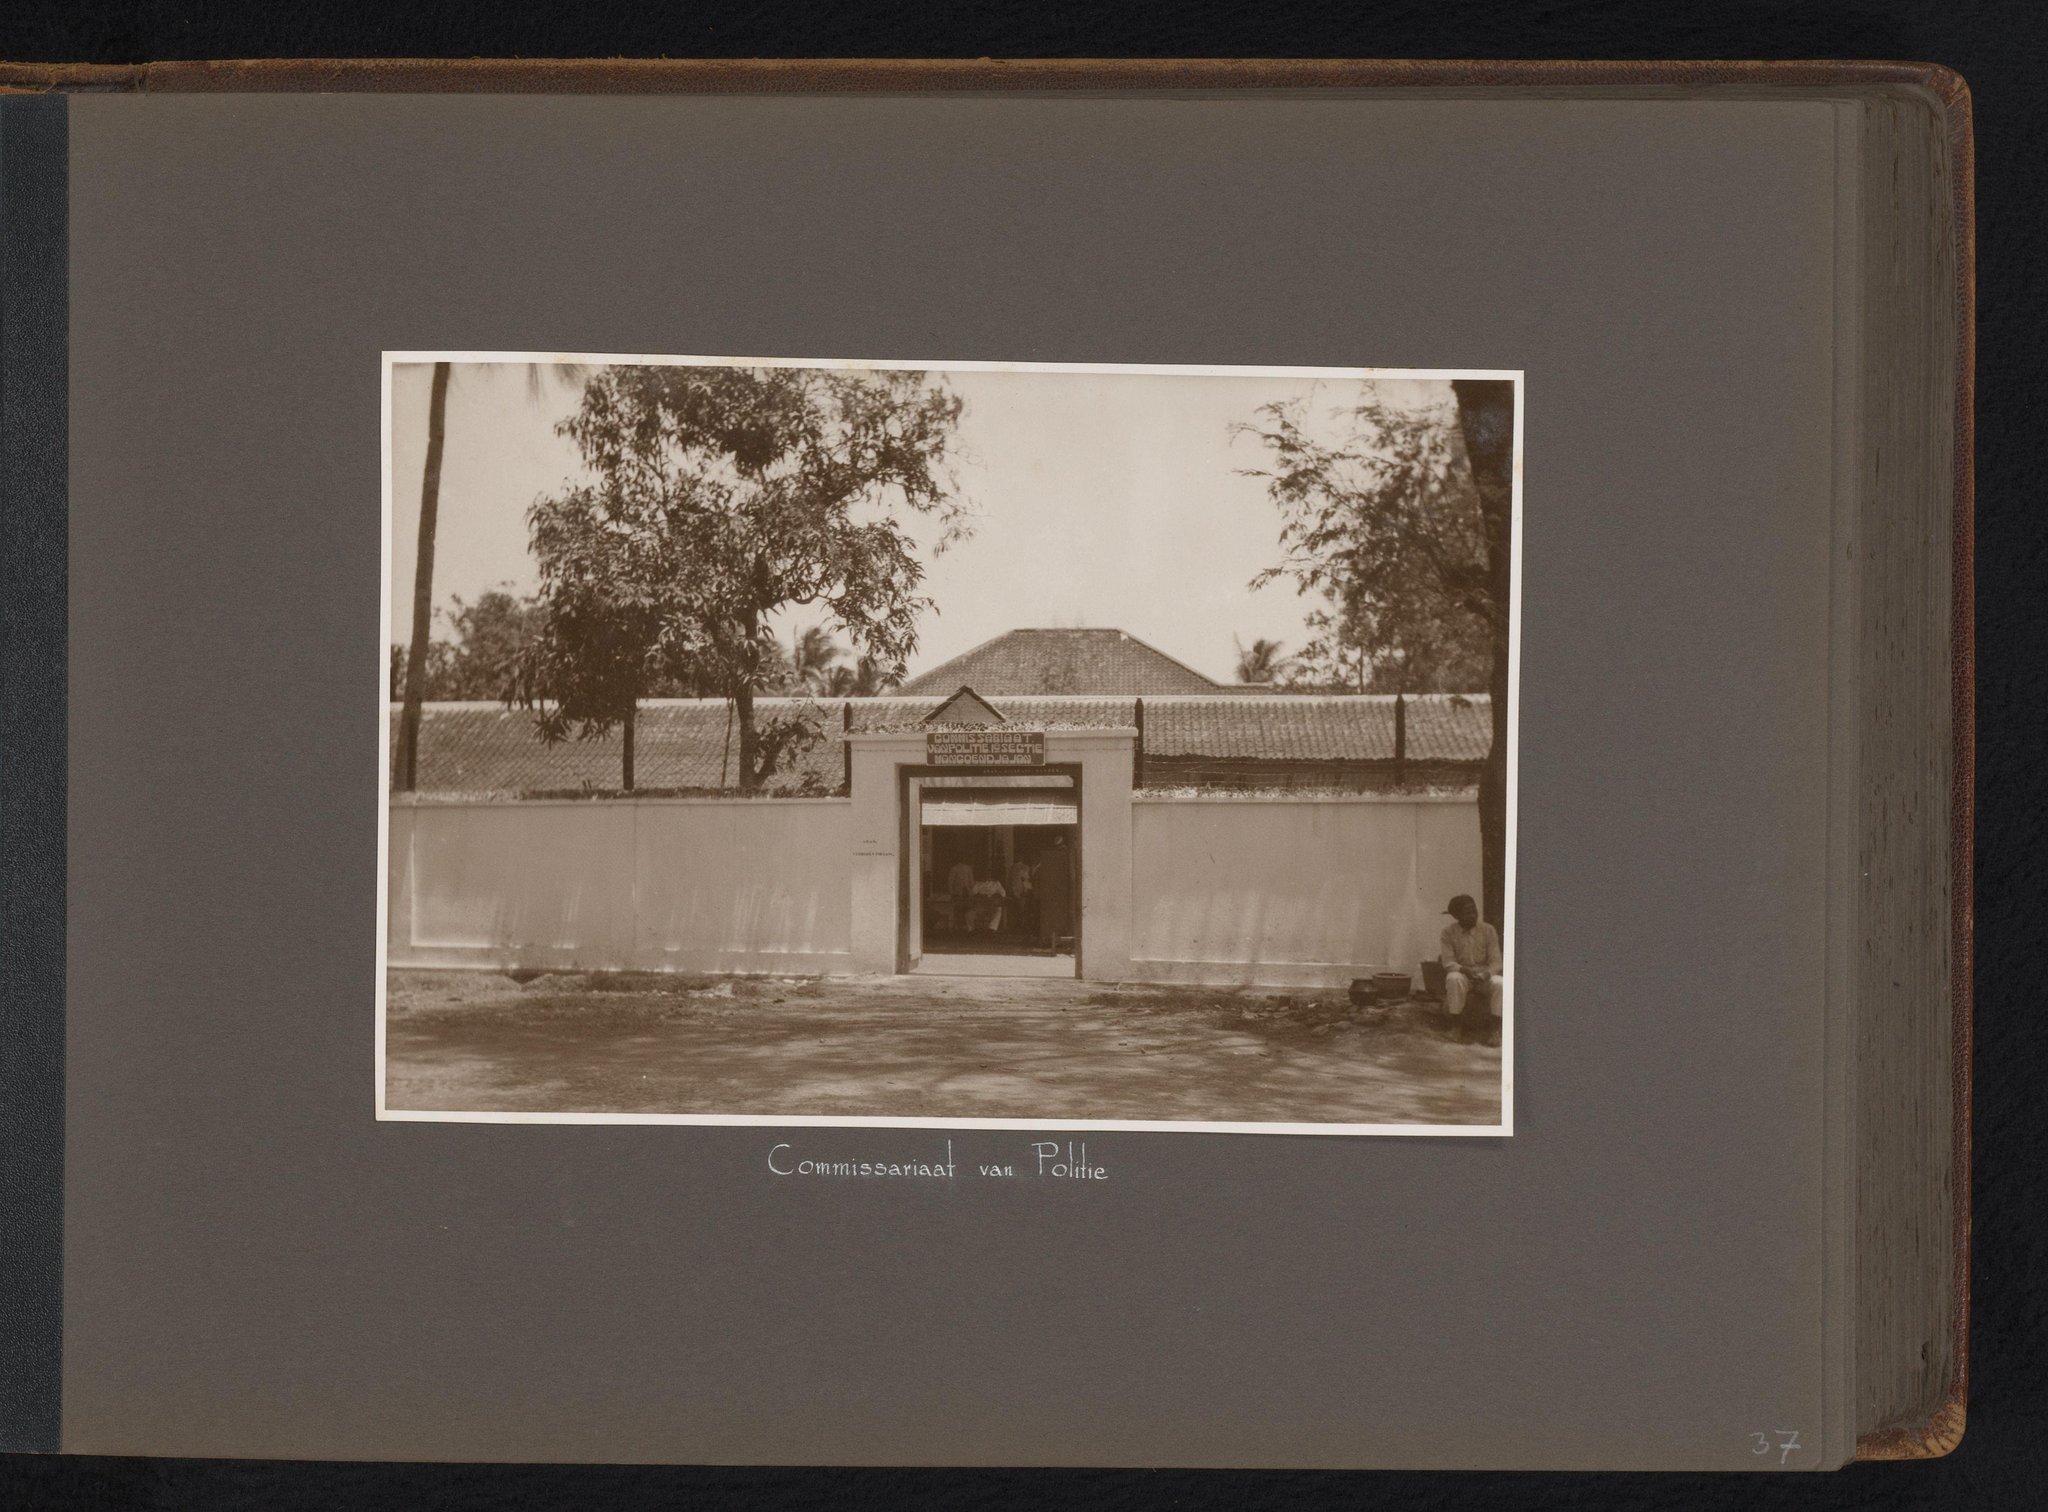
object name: photograph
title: Commissariaat van Politie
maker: Anonymous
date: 1925-1931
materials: cardboard, photographic support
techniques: gelatin silver print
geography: solo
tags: dutch east indies, the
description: Albumblad met één foto: het gebouw van het commissariaat van politie eerste sectie, in Mangoendjajan te Solo. Onderdeel van het fotoalbum aangeboden aan S. Koster door de Vereeniging van Hoogere Politie Ambtenaren in Nederlandsch-Indië in 1931.